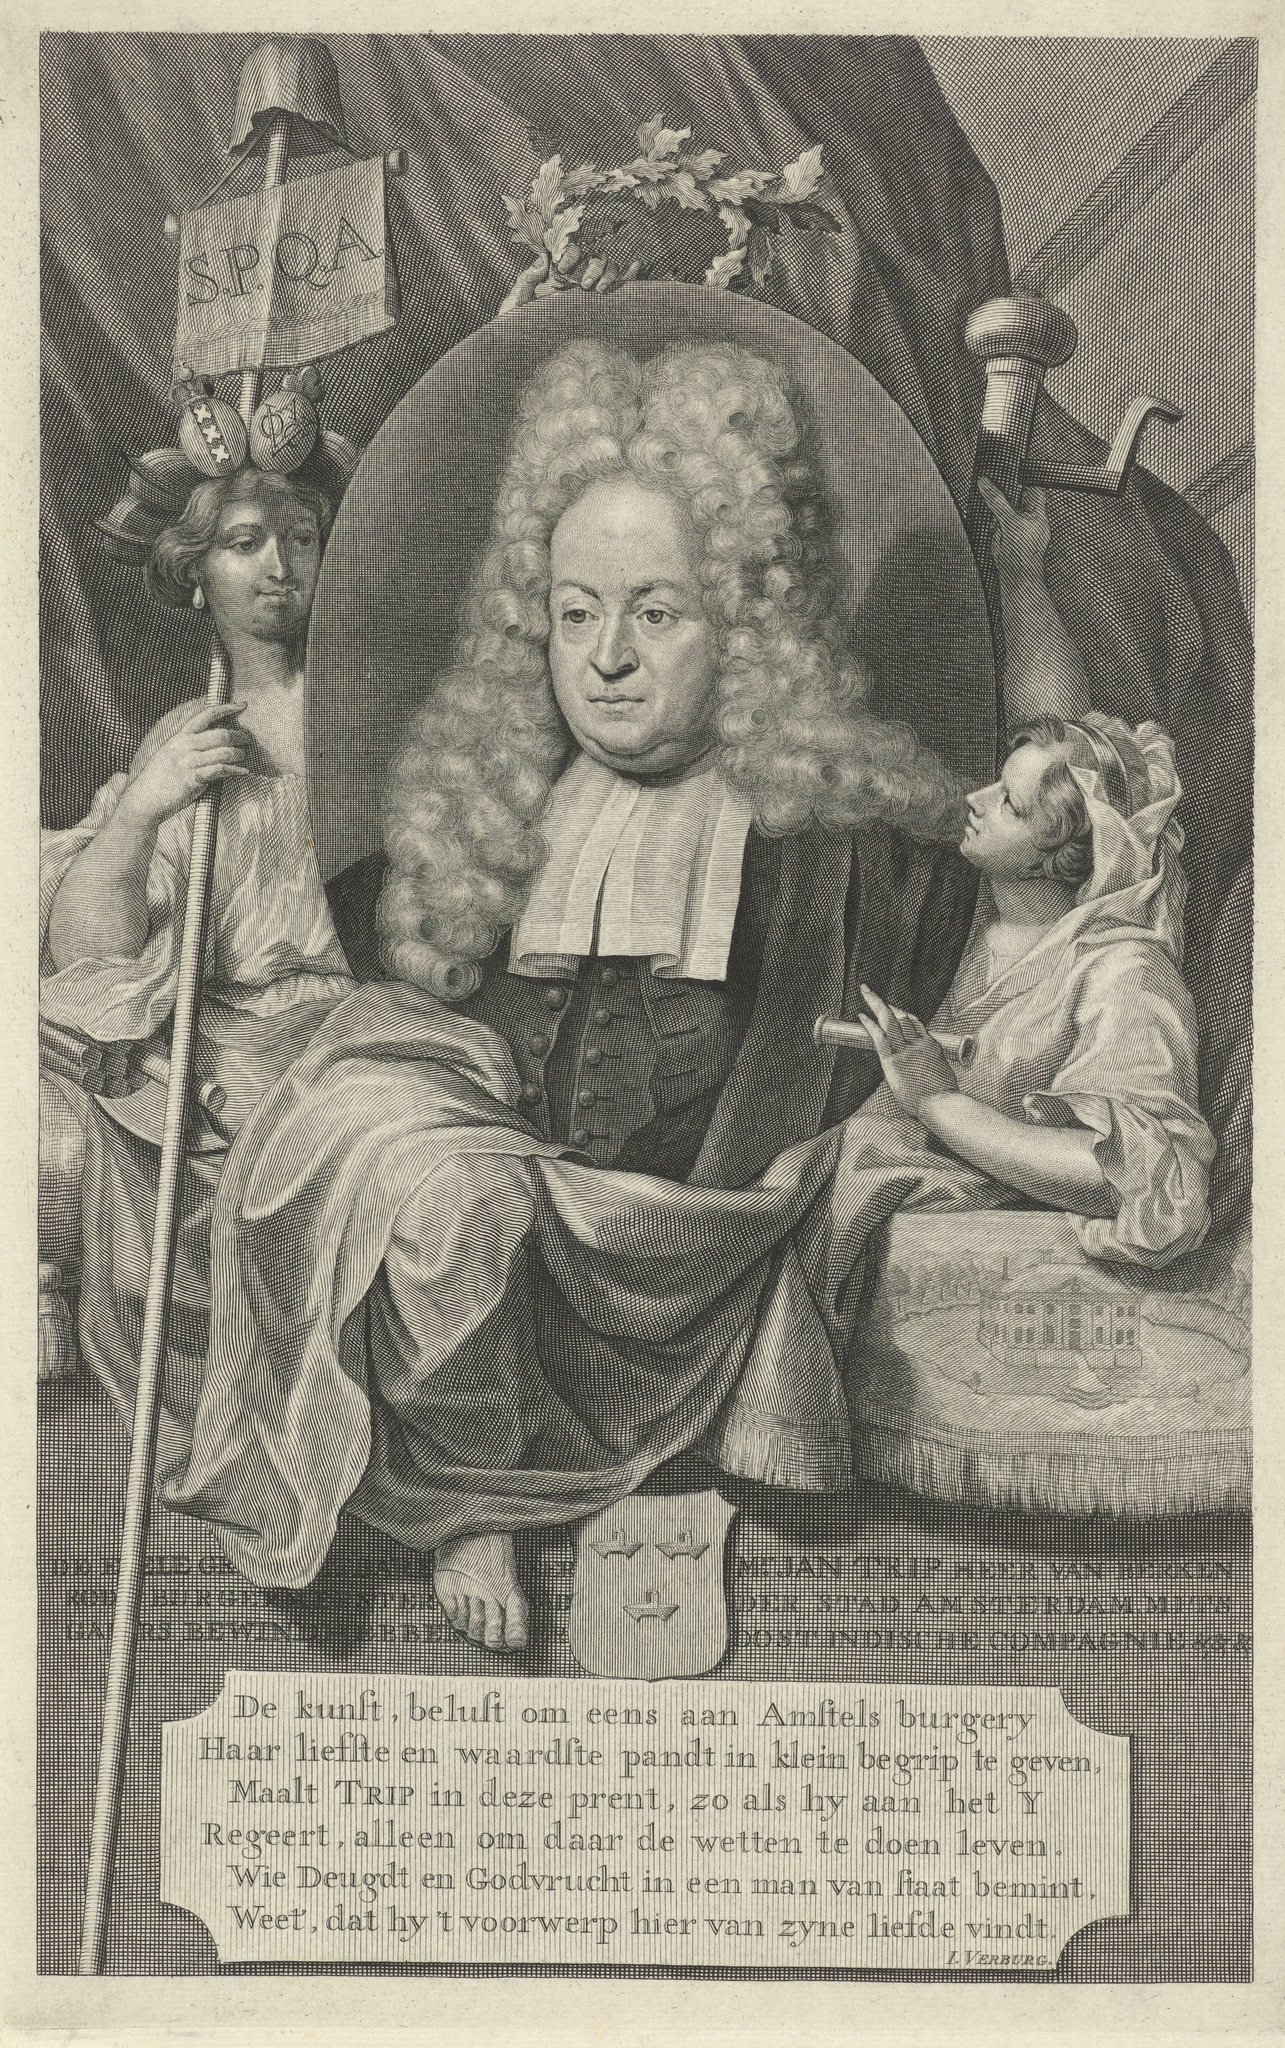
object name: print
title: Portret van Jan Trip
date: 1708-1780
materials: paper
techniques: engraving